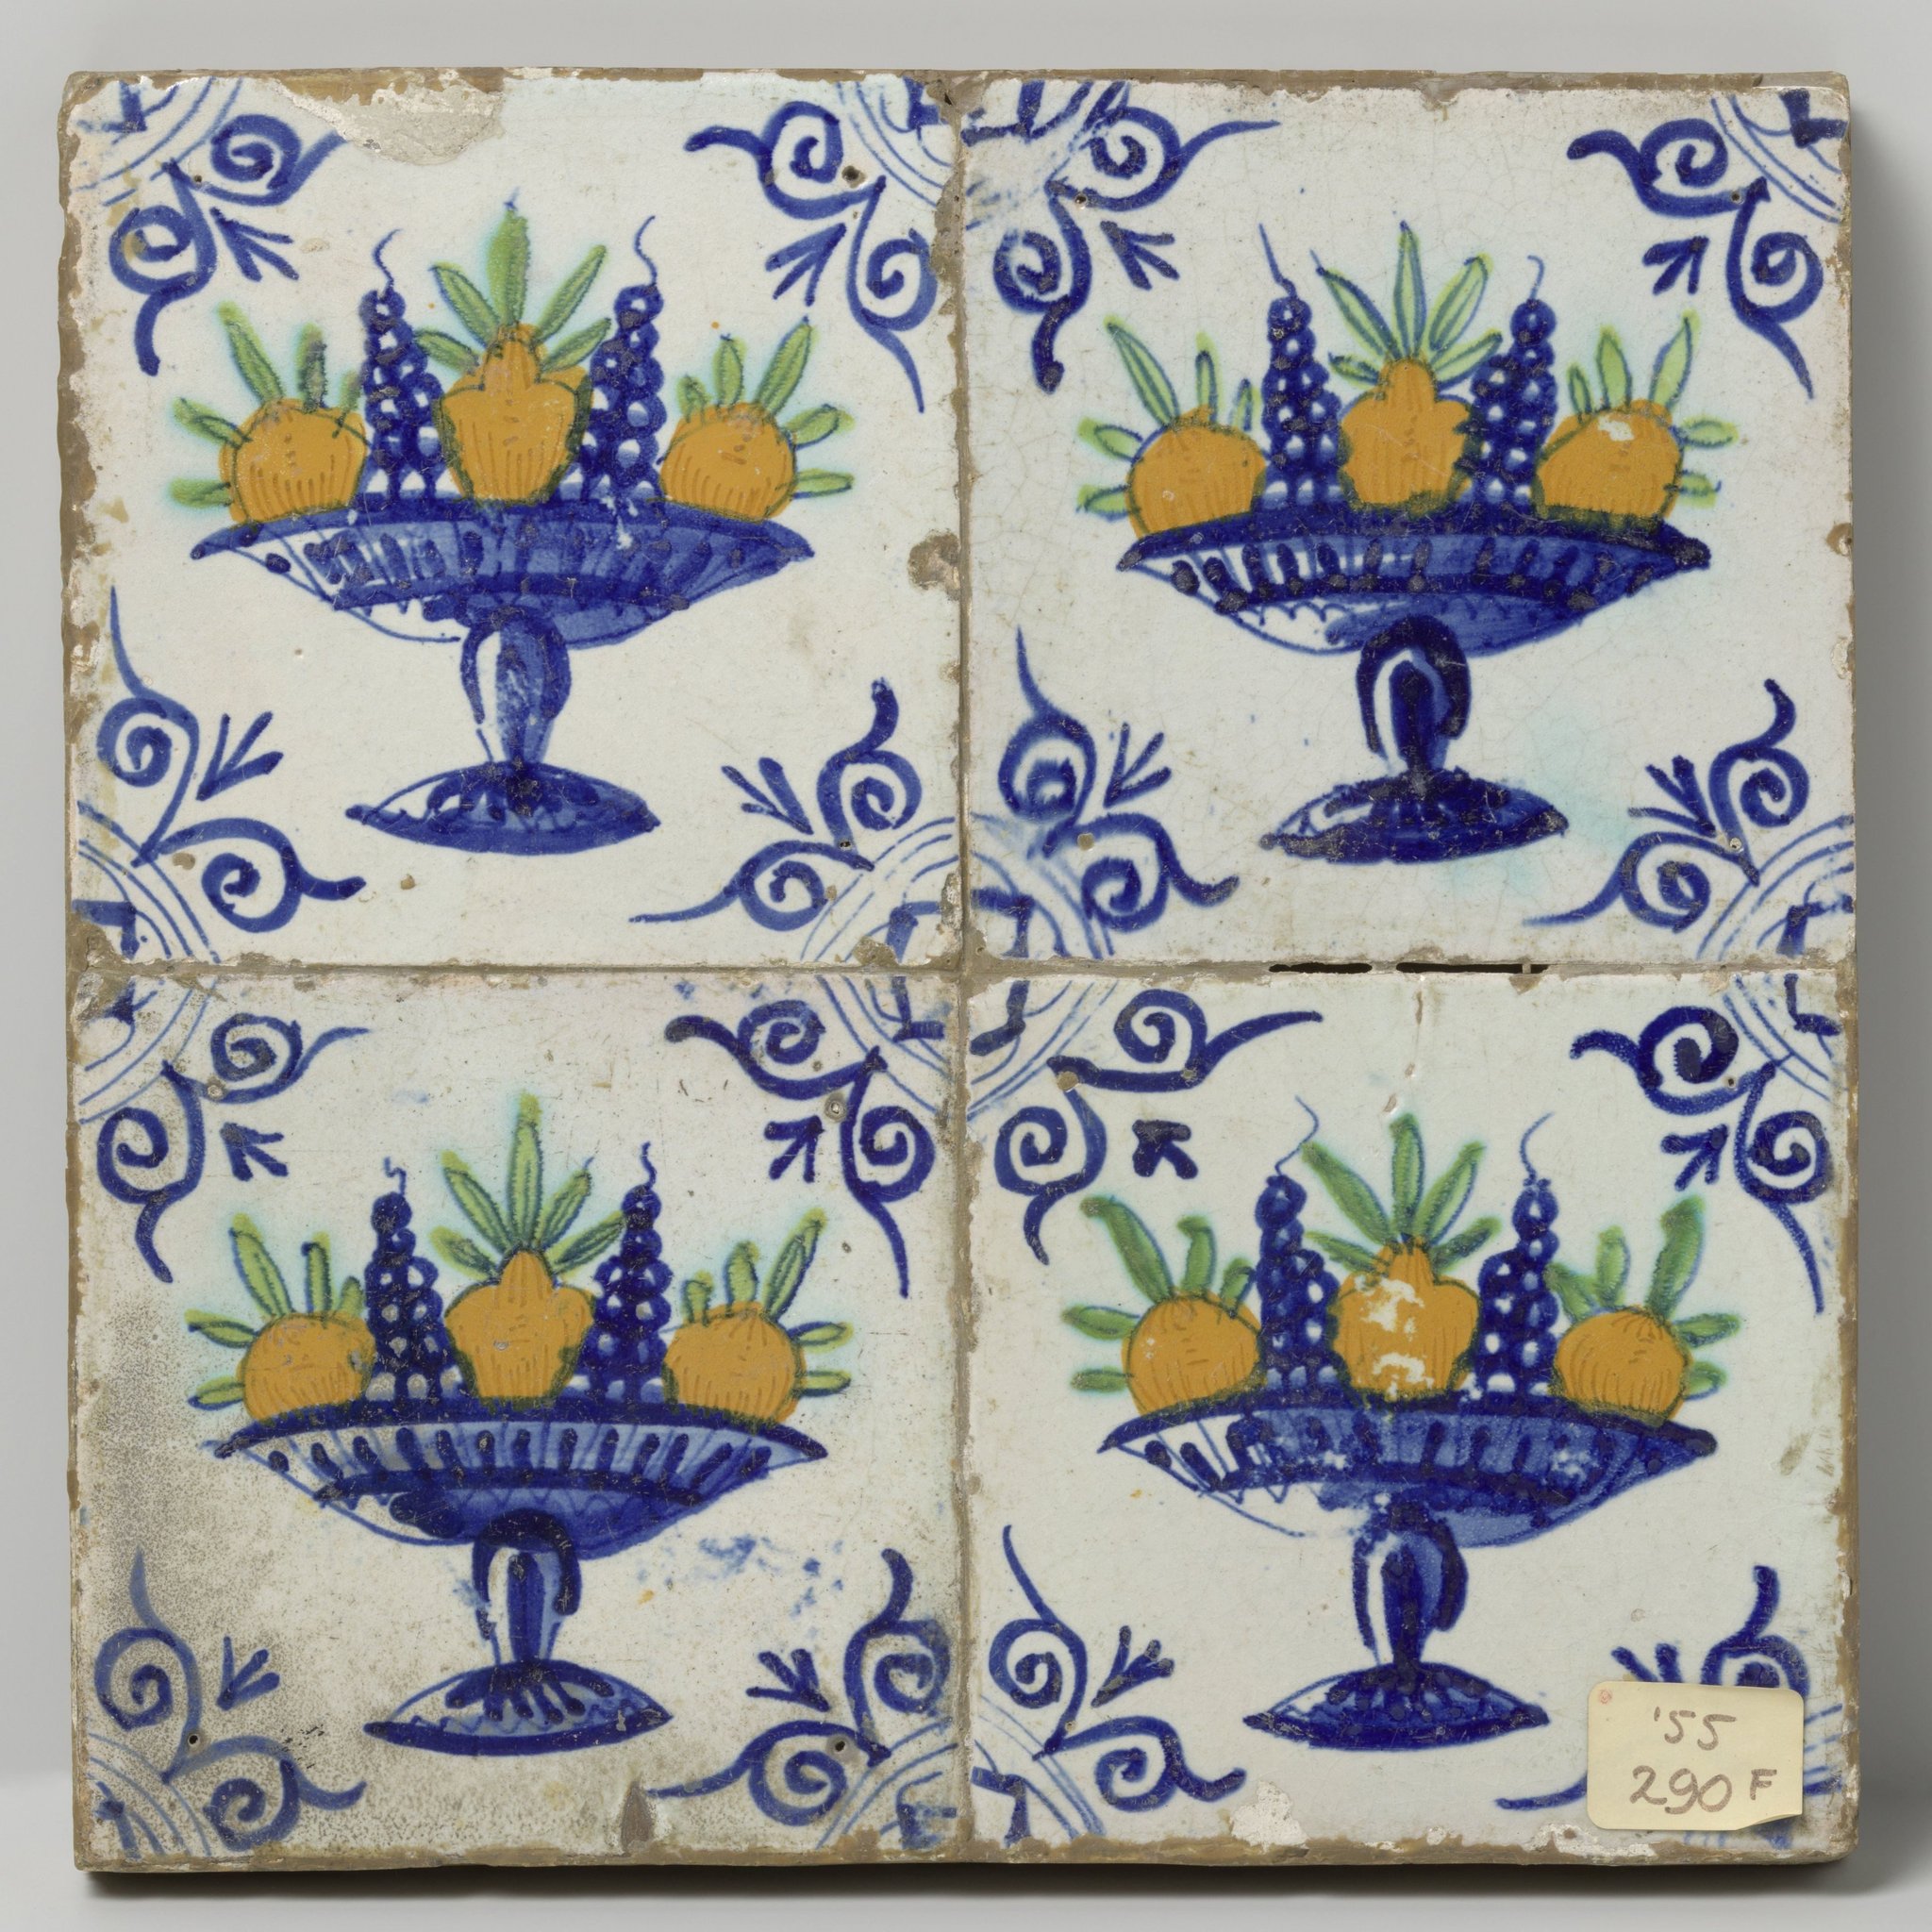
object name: tegelveld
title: Veld van vier tegels met fruitschalen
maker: Anonymous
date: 1620-1640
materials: earthenware, glaze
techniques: maiolica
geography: netherlands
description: Veld van vier tegels (2 x 2) elk met een veelkleurige (blauw, groen, geel en oranje) geschilderde fruitschaal. In de hoeken, een ossenkop.